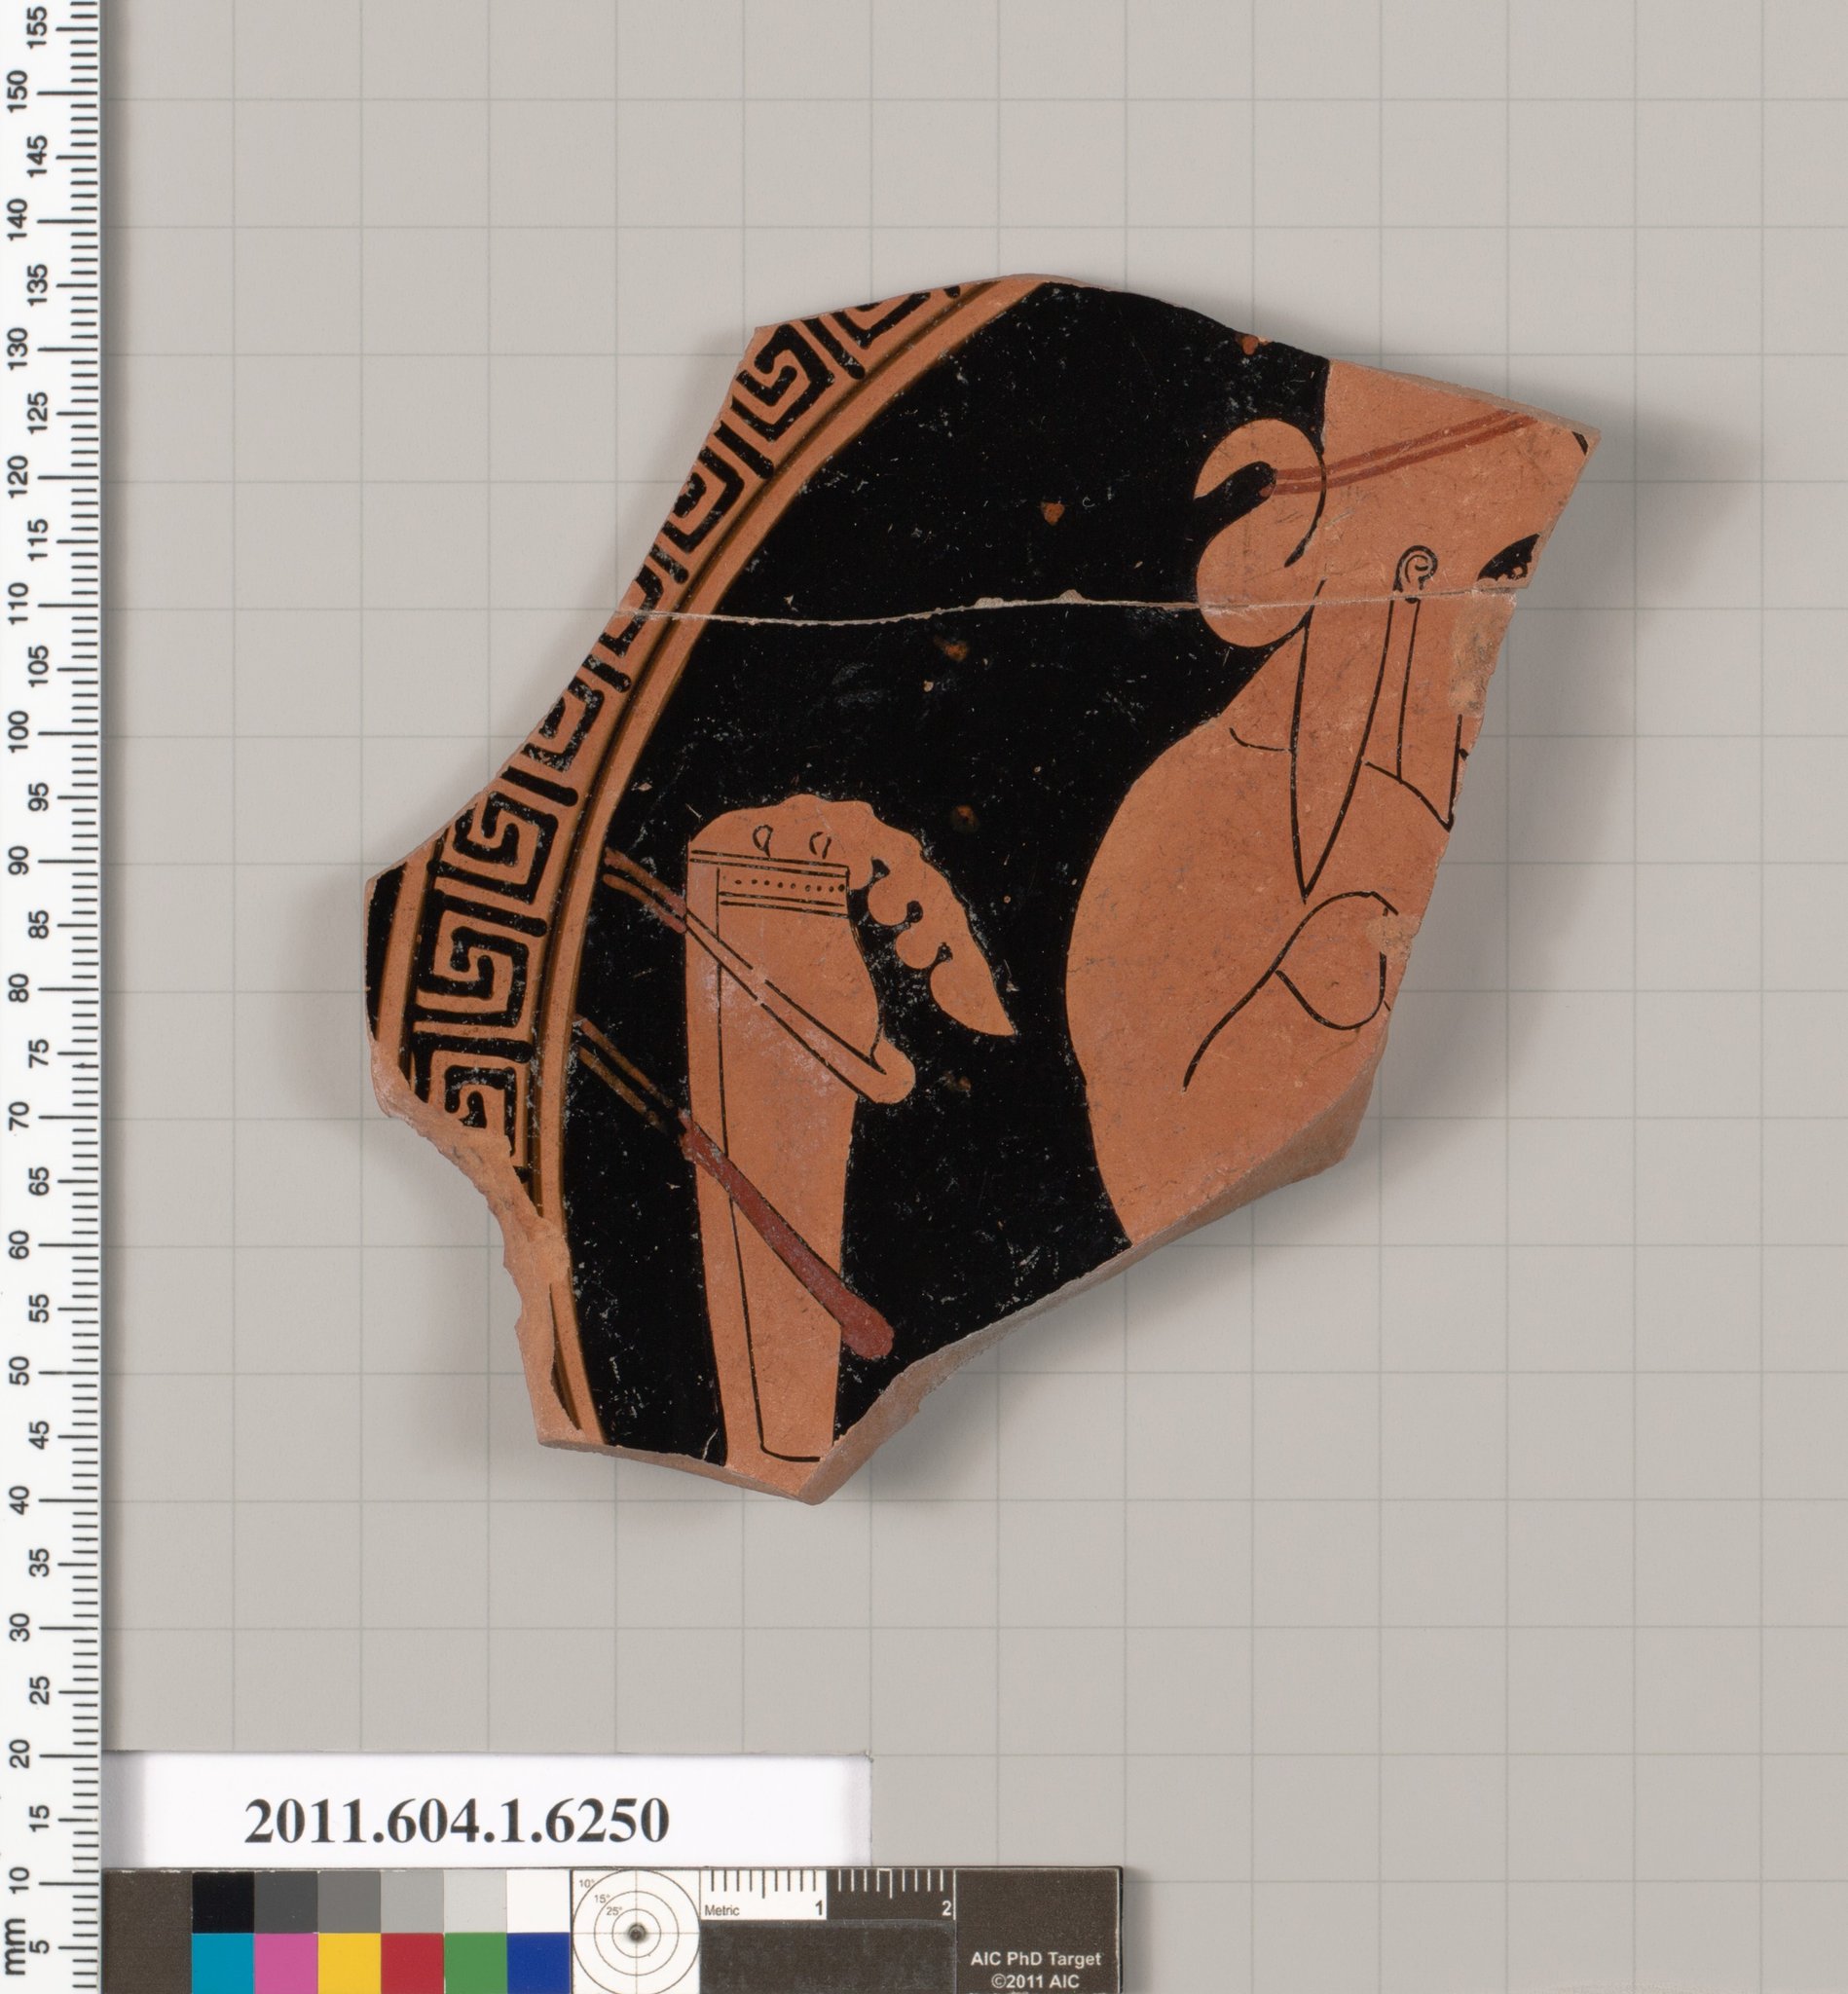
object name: kylix fragment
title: Terracotta fragment of a kylix (drinking cup)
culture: greek, attic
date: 500-480 BCE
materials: terracotta